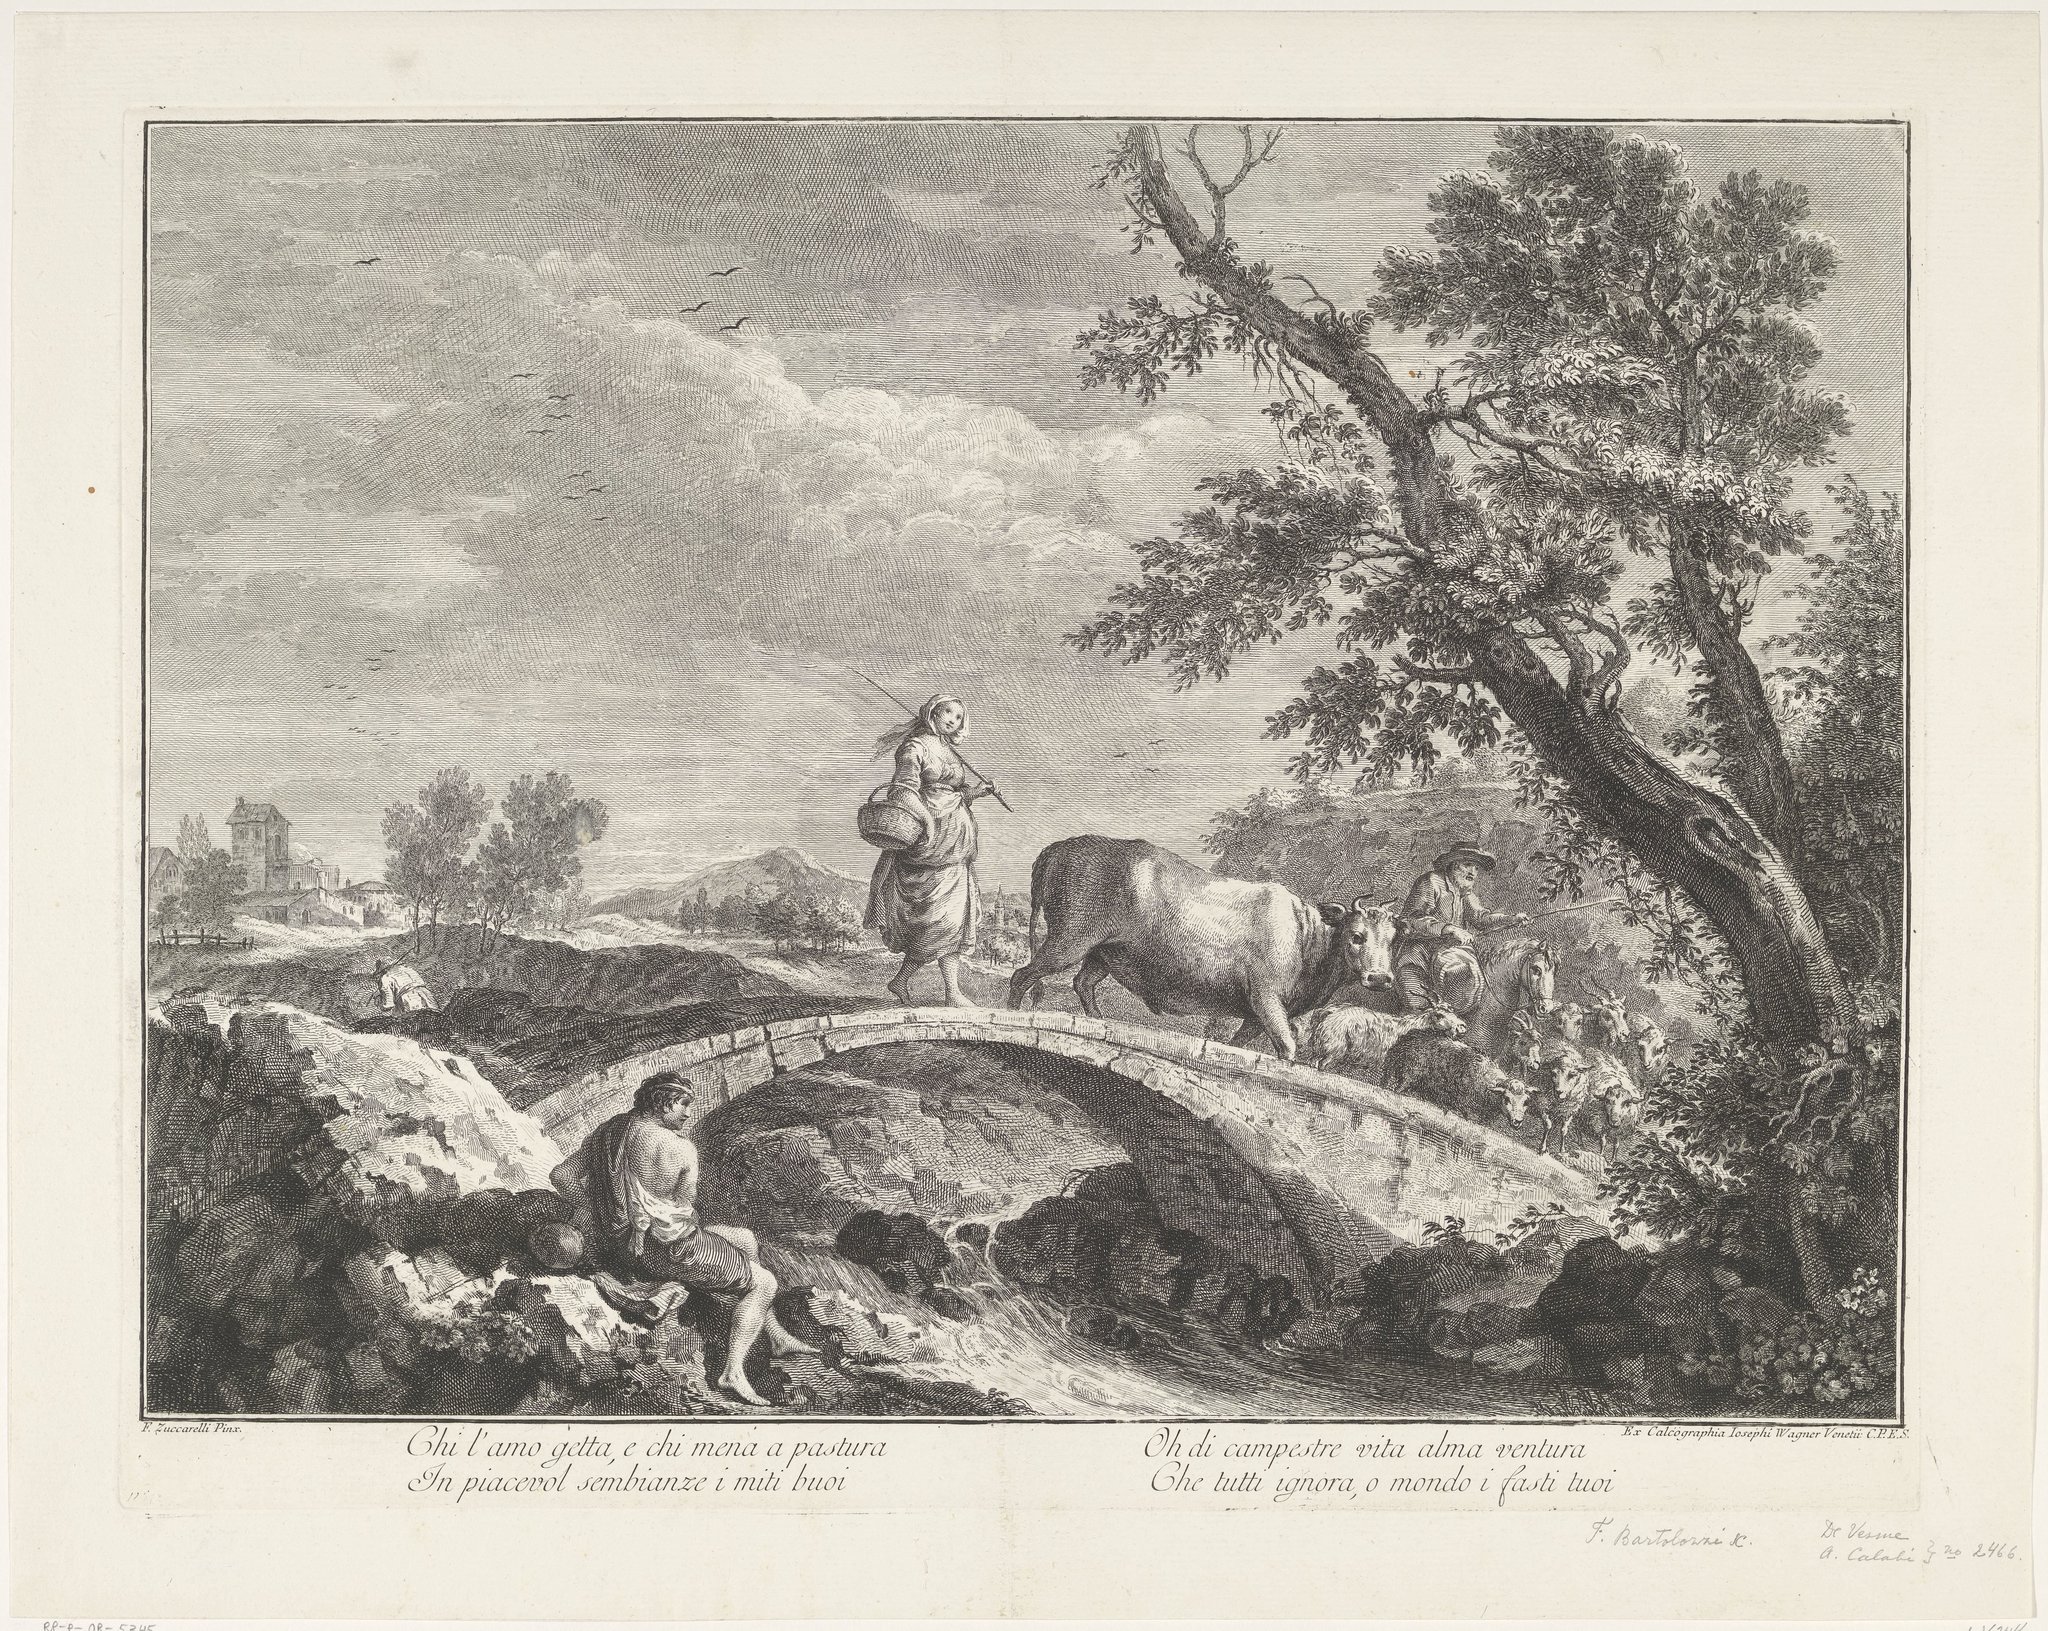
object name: print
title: Landschappen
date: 1762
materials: paper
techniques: engraving, etching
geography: italy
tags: city-view, and landscape with man-made constructions, herding, herdsman, herdswoman, shepherd, shepherdess, cowherd, etc., bridge, herd, flock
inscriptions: collector's mark: Lugt 240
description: Landschap met een herder en een herderin die met hun kudde over een bruggetje lopen. Aan de waterkant links zit een man. Italiaans vers in ondermarge.